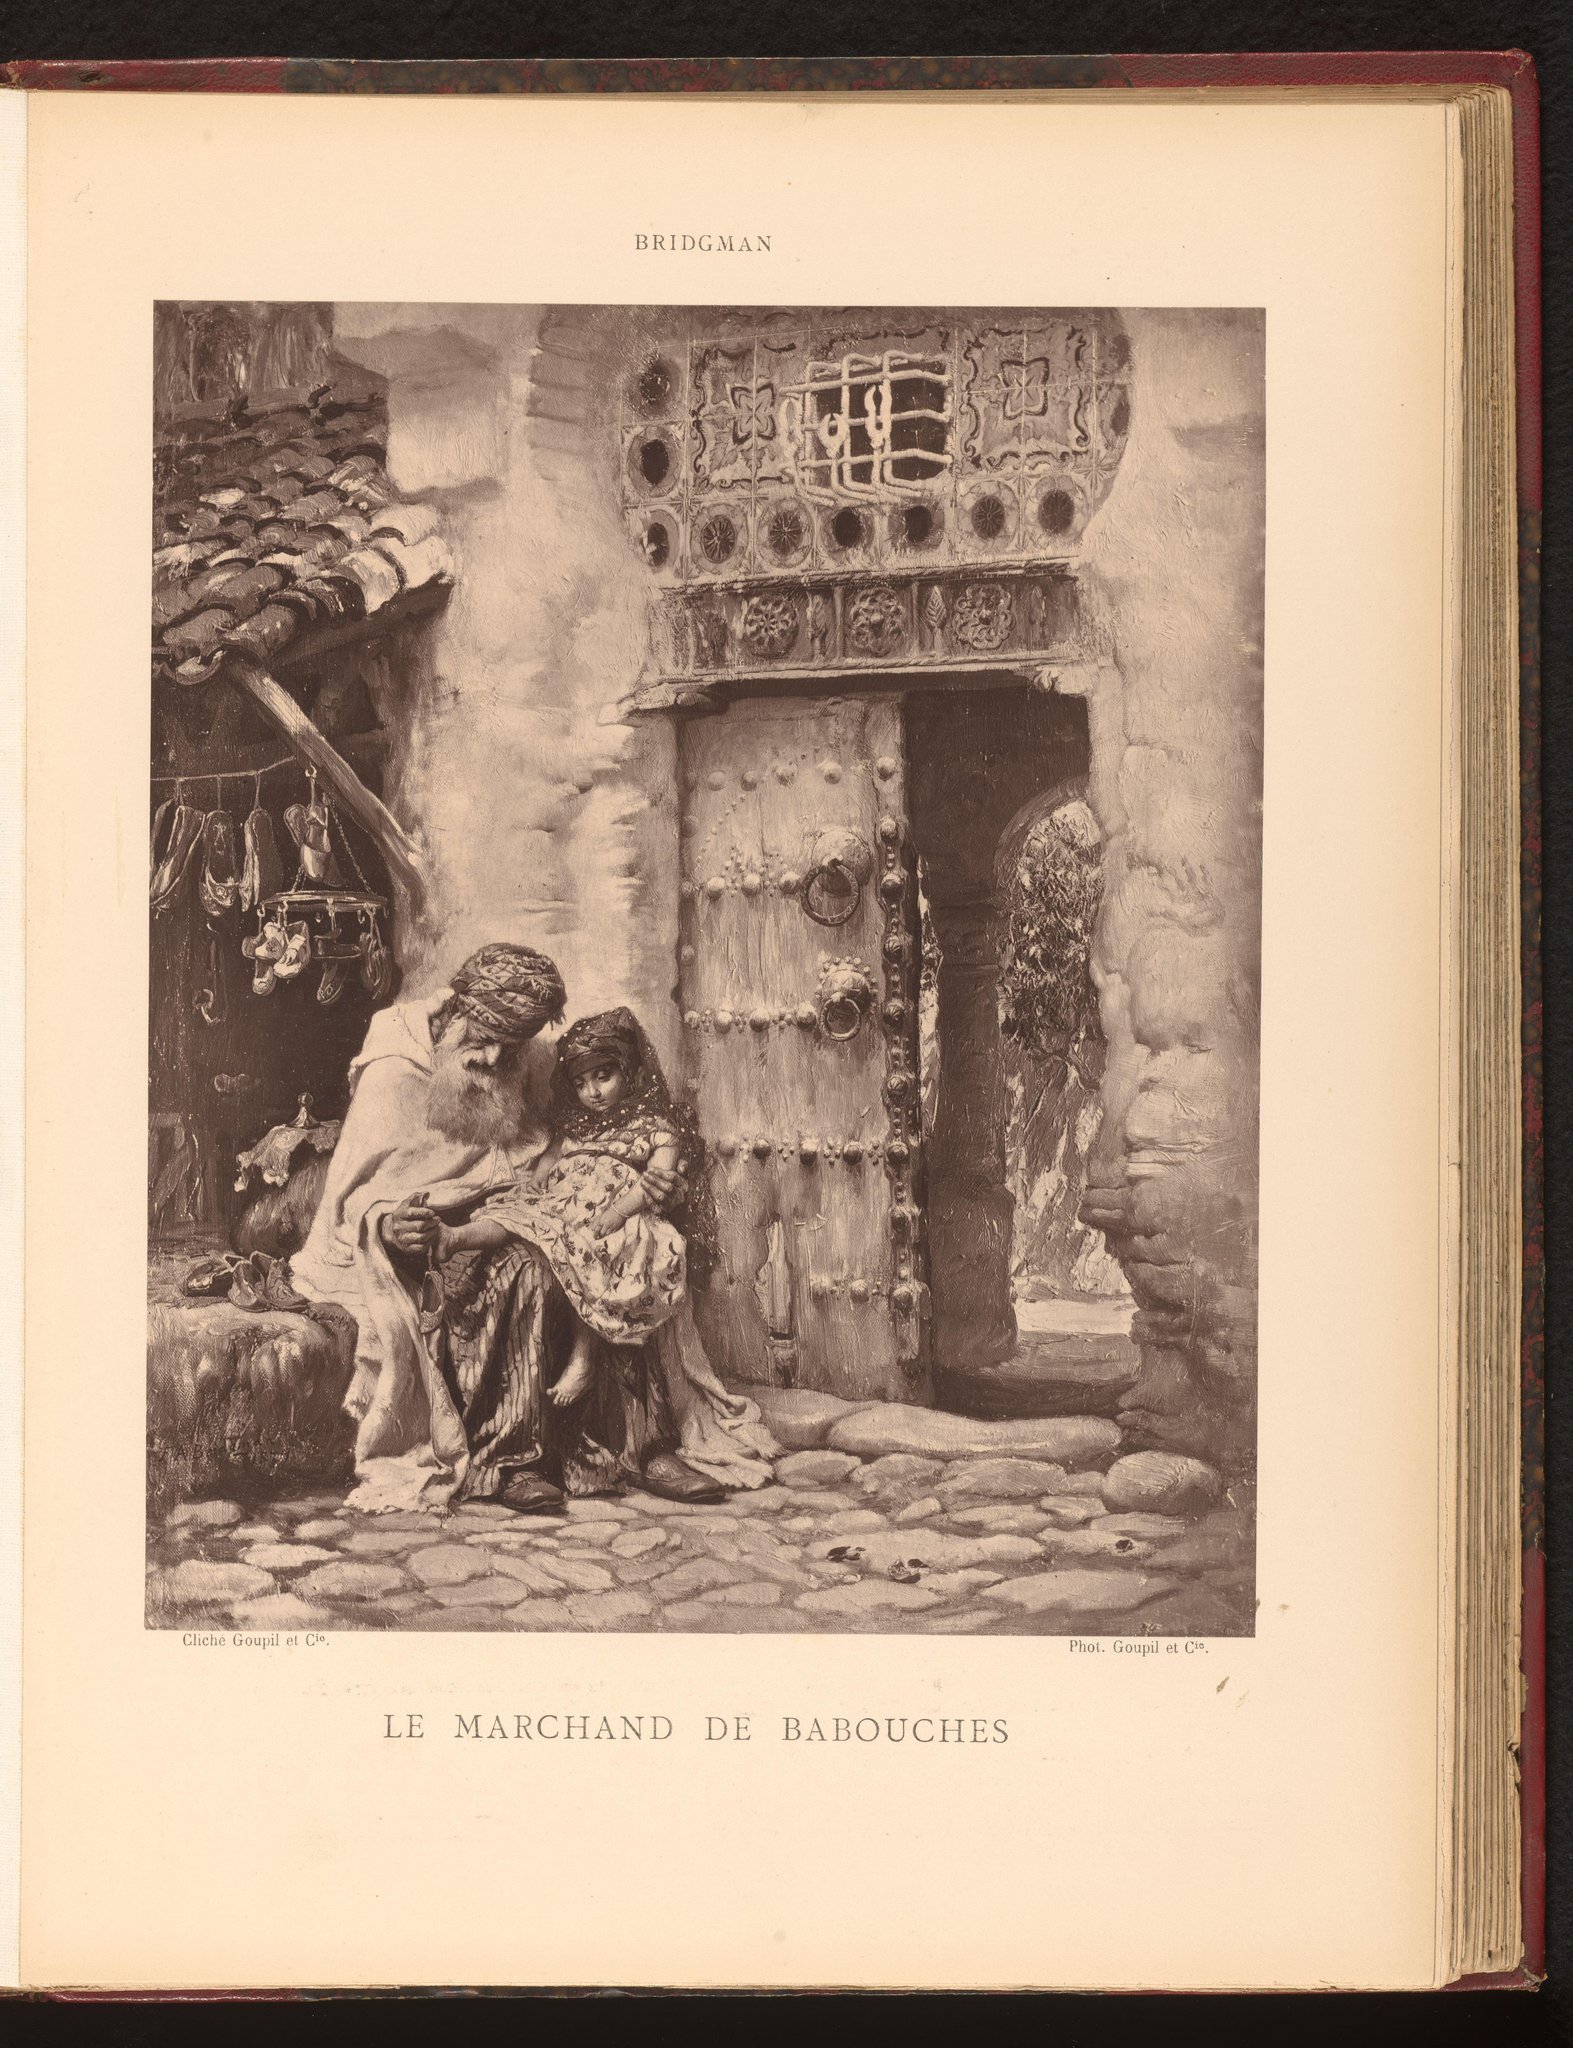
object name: photomechanical print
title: Le marchand de babouches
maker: frederick arthur bridgman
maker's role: painter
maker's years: 1847-1928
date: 1877-1882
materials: paper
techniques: woodburytype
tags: toddler (female), merchant, salesman